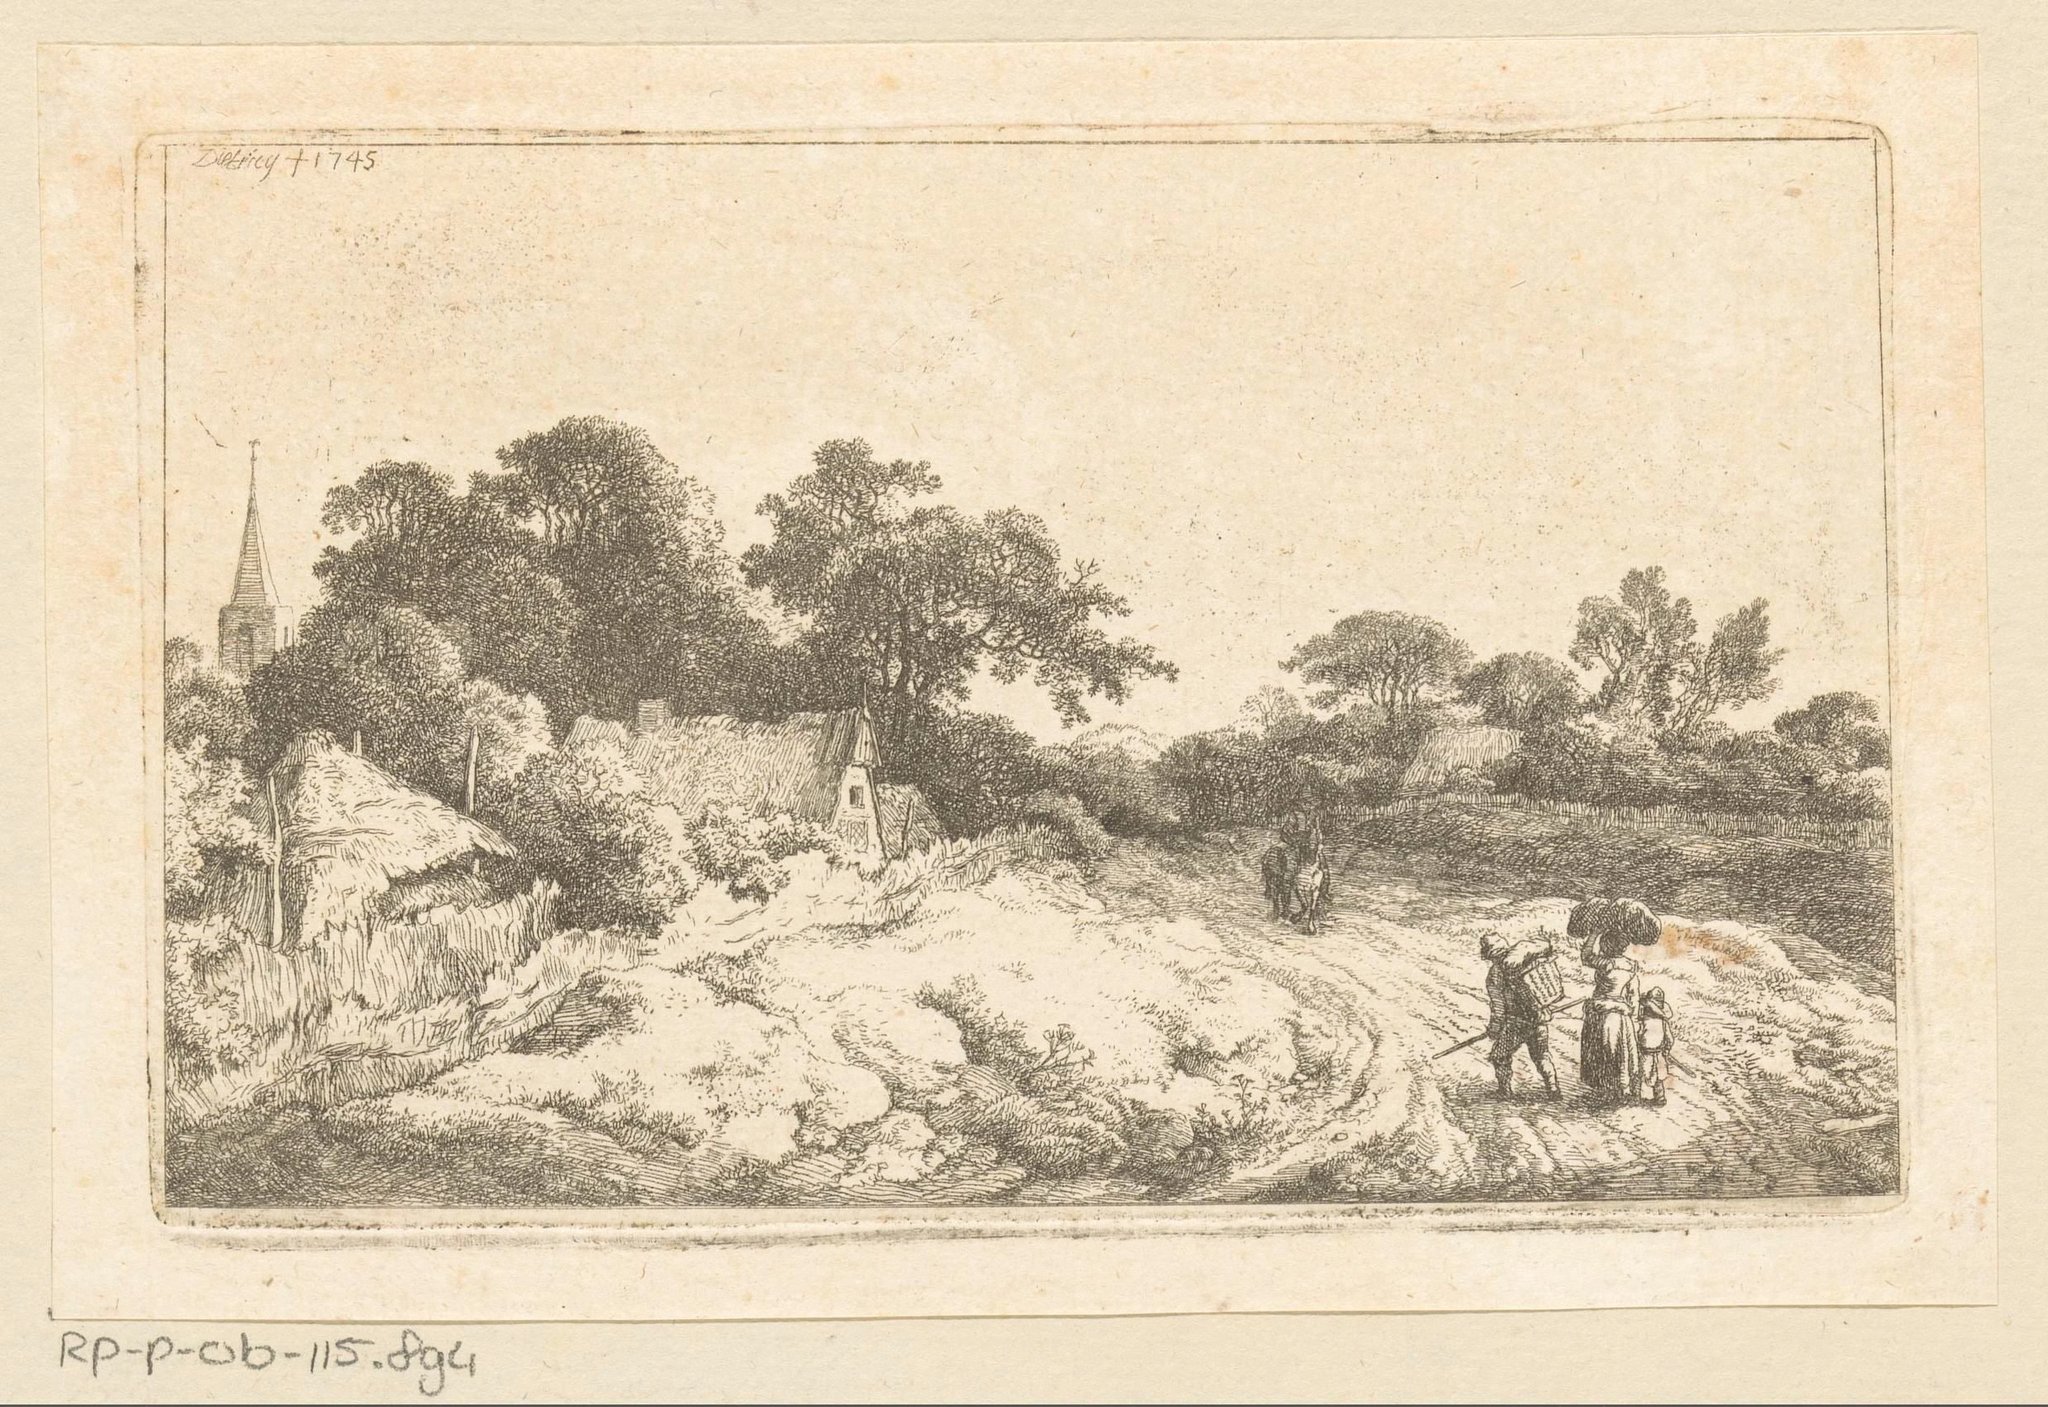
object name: print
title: Landschap met dorp en langslopend pad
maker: christian wilhelm ernst dietrich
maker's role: artist, painter, print maker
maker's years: 1712-1774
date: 1745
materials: paper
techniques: etching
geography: dresden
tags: city-view, and landscape with man-made constructions, road, path, walking, carrying something on the head or on the shoulders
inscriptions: collector's mark: Lugt 240